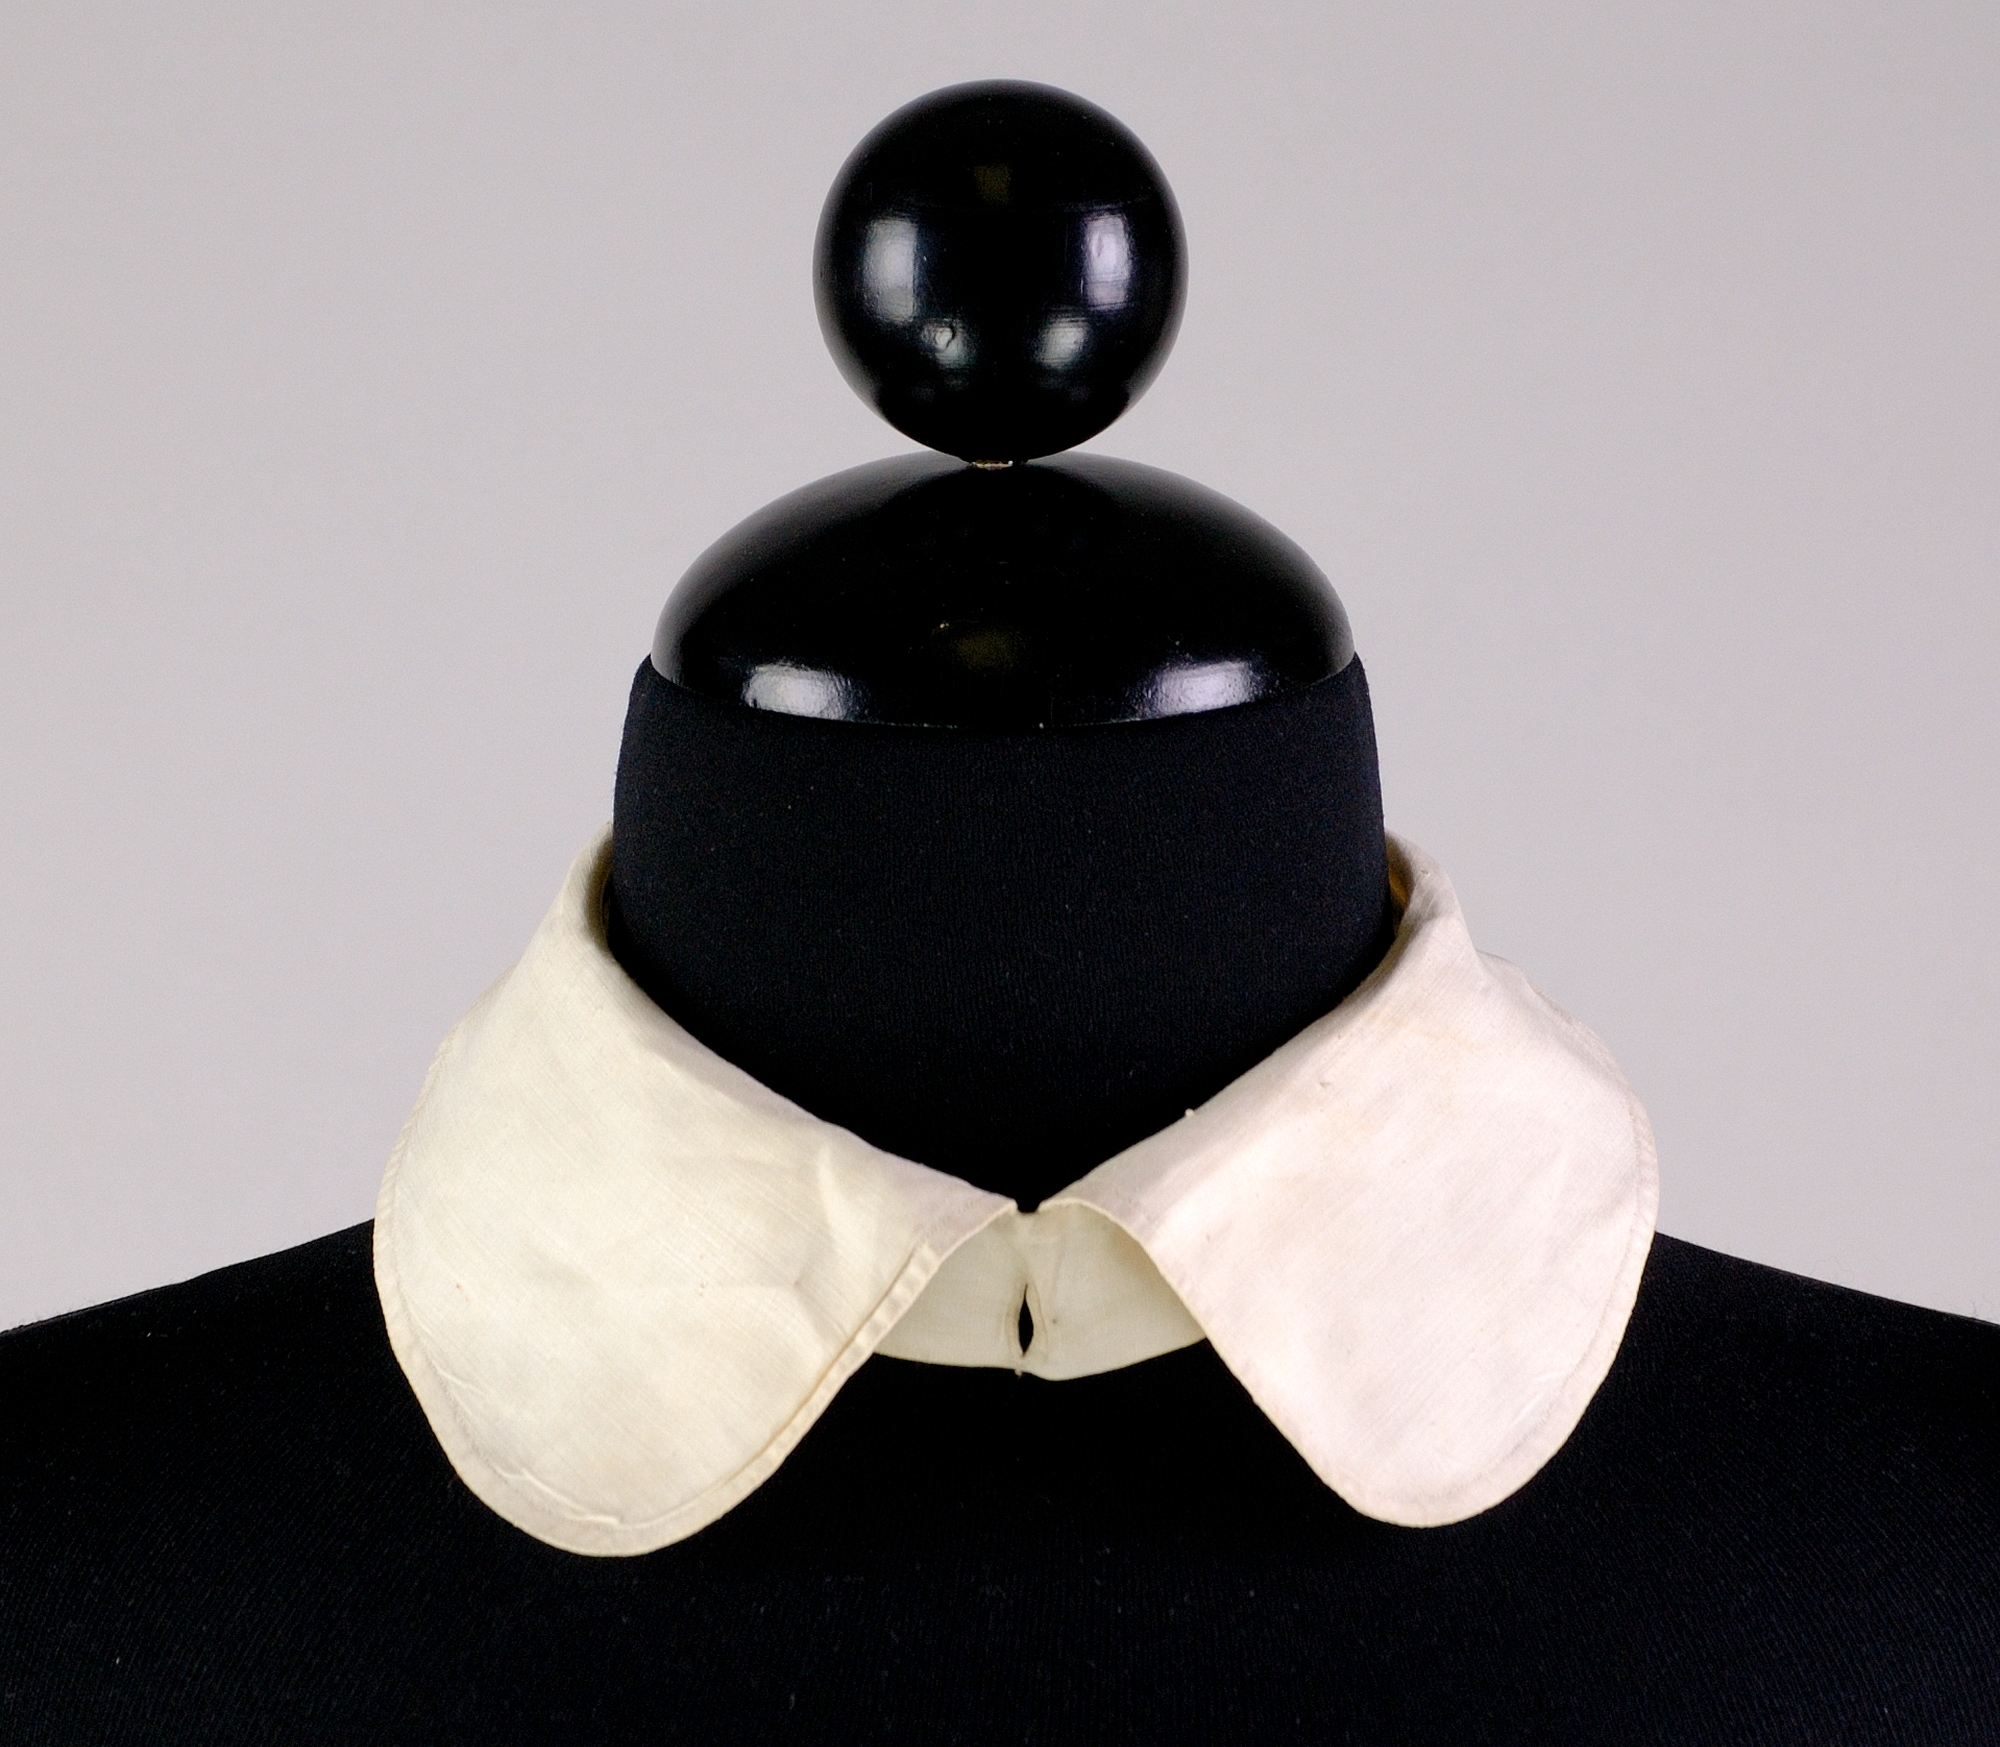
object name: collar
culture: american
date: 1830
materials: linen